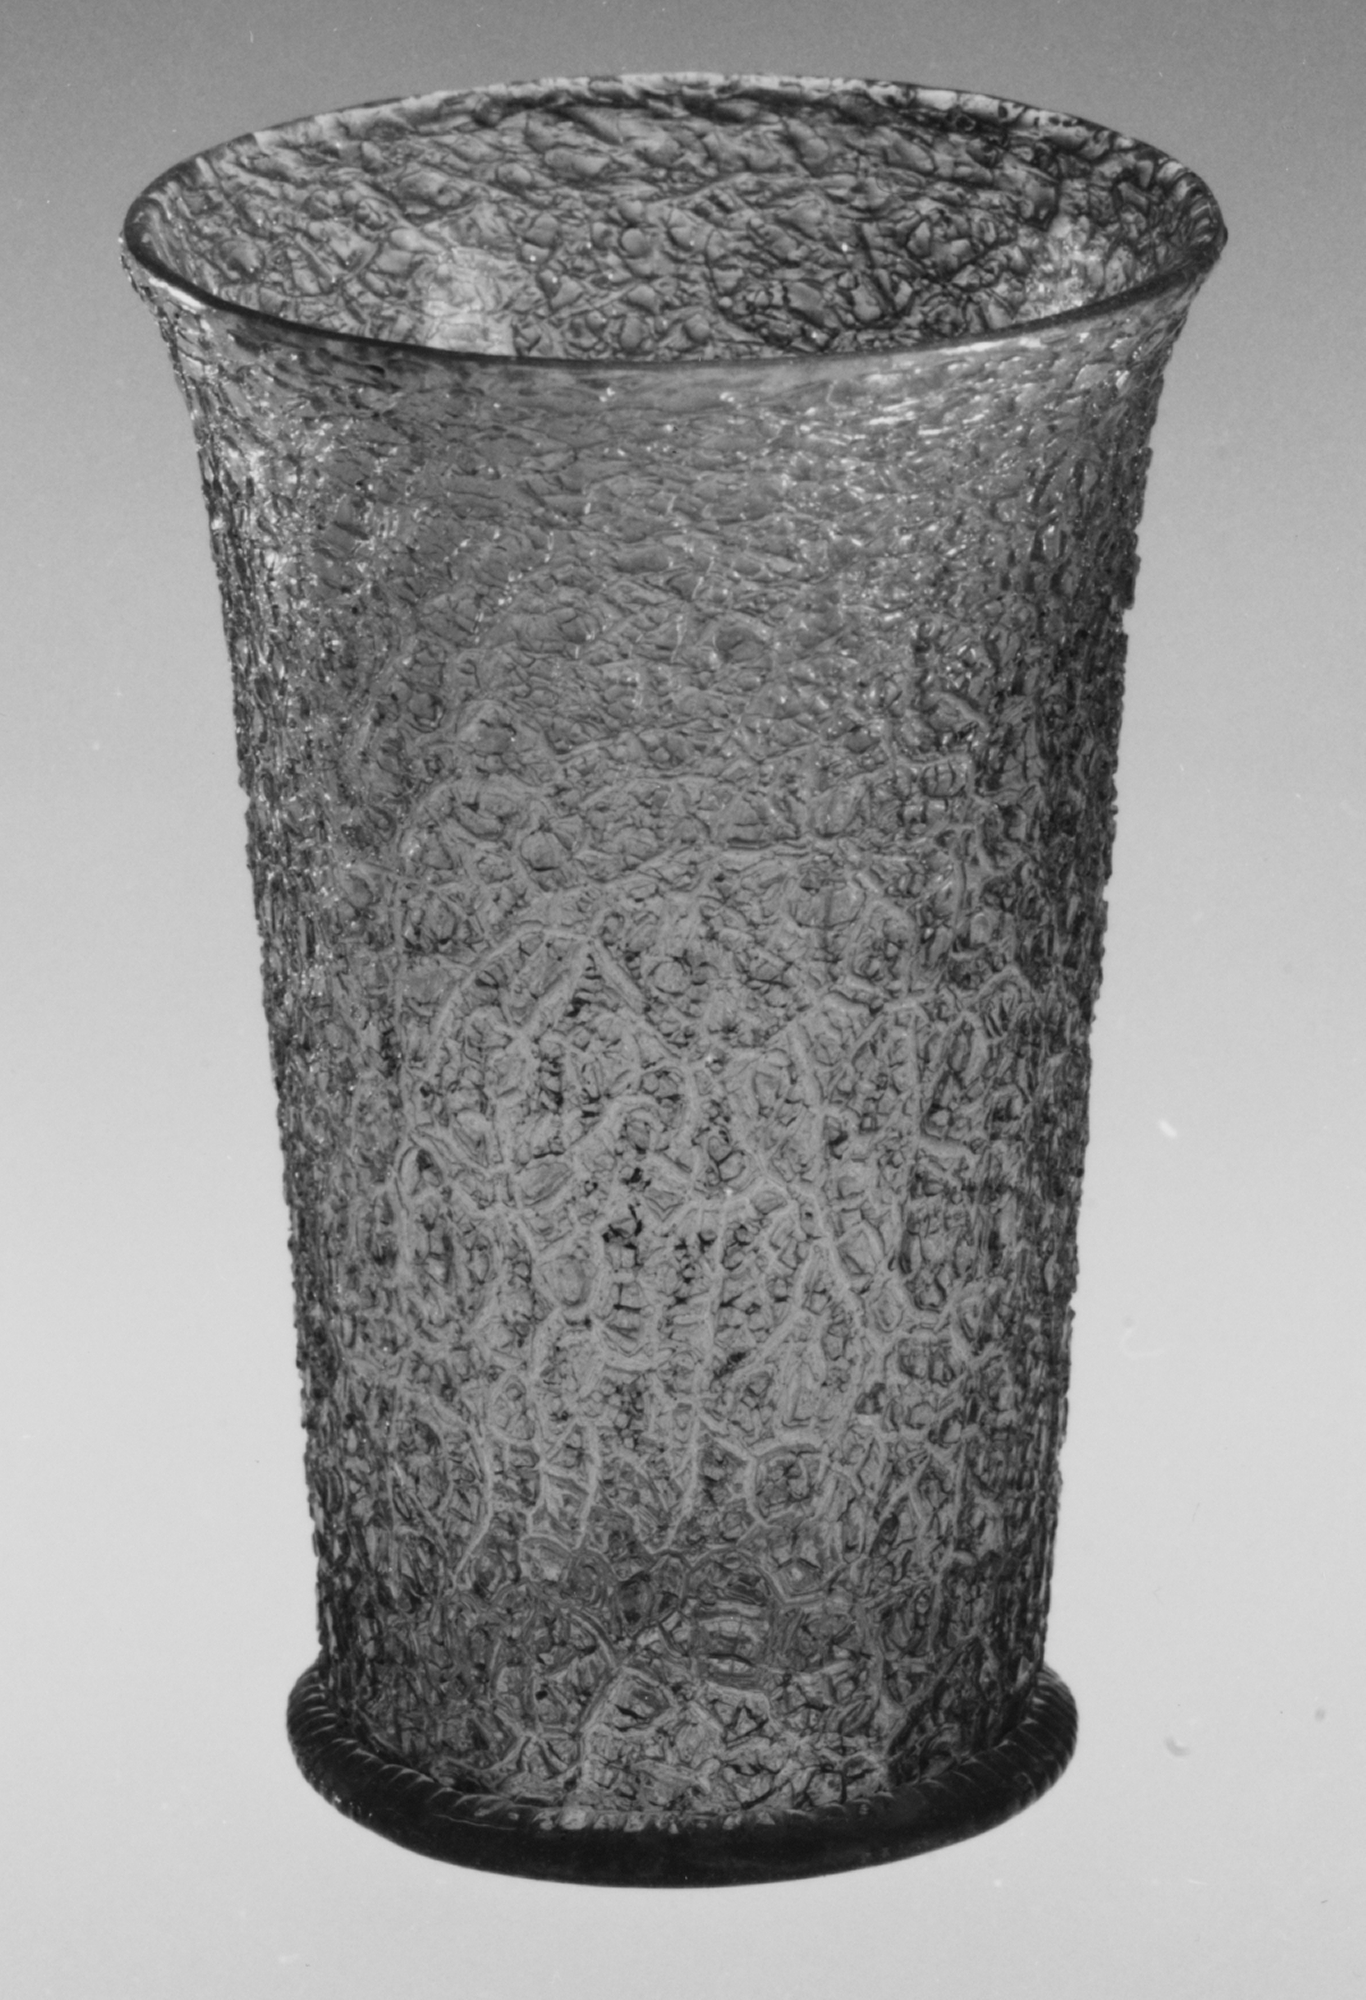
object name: beaker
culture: italian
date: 1567-1633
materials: gilt, glass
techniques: glassblowing